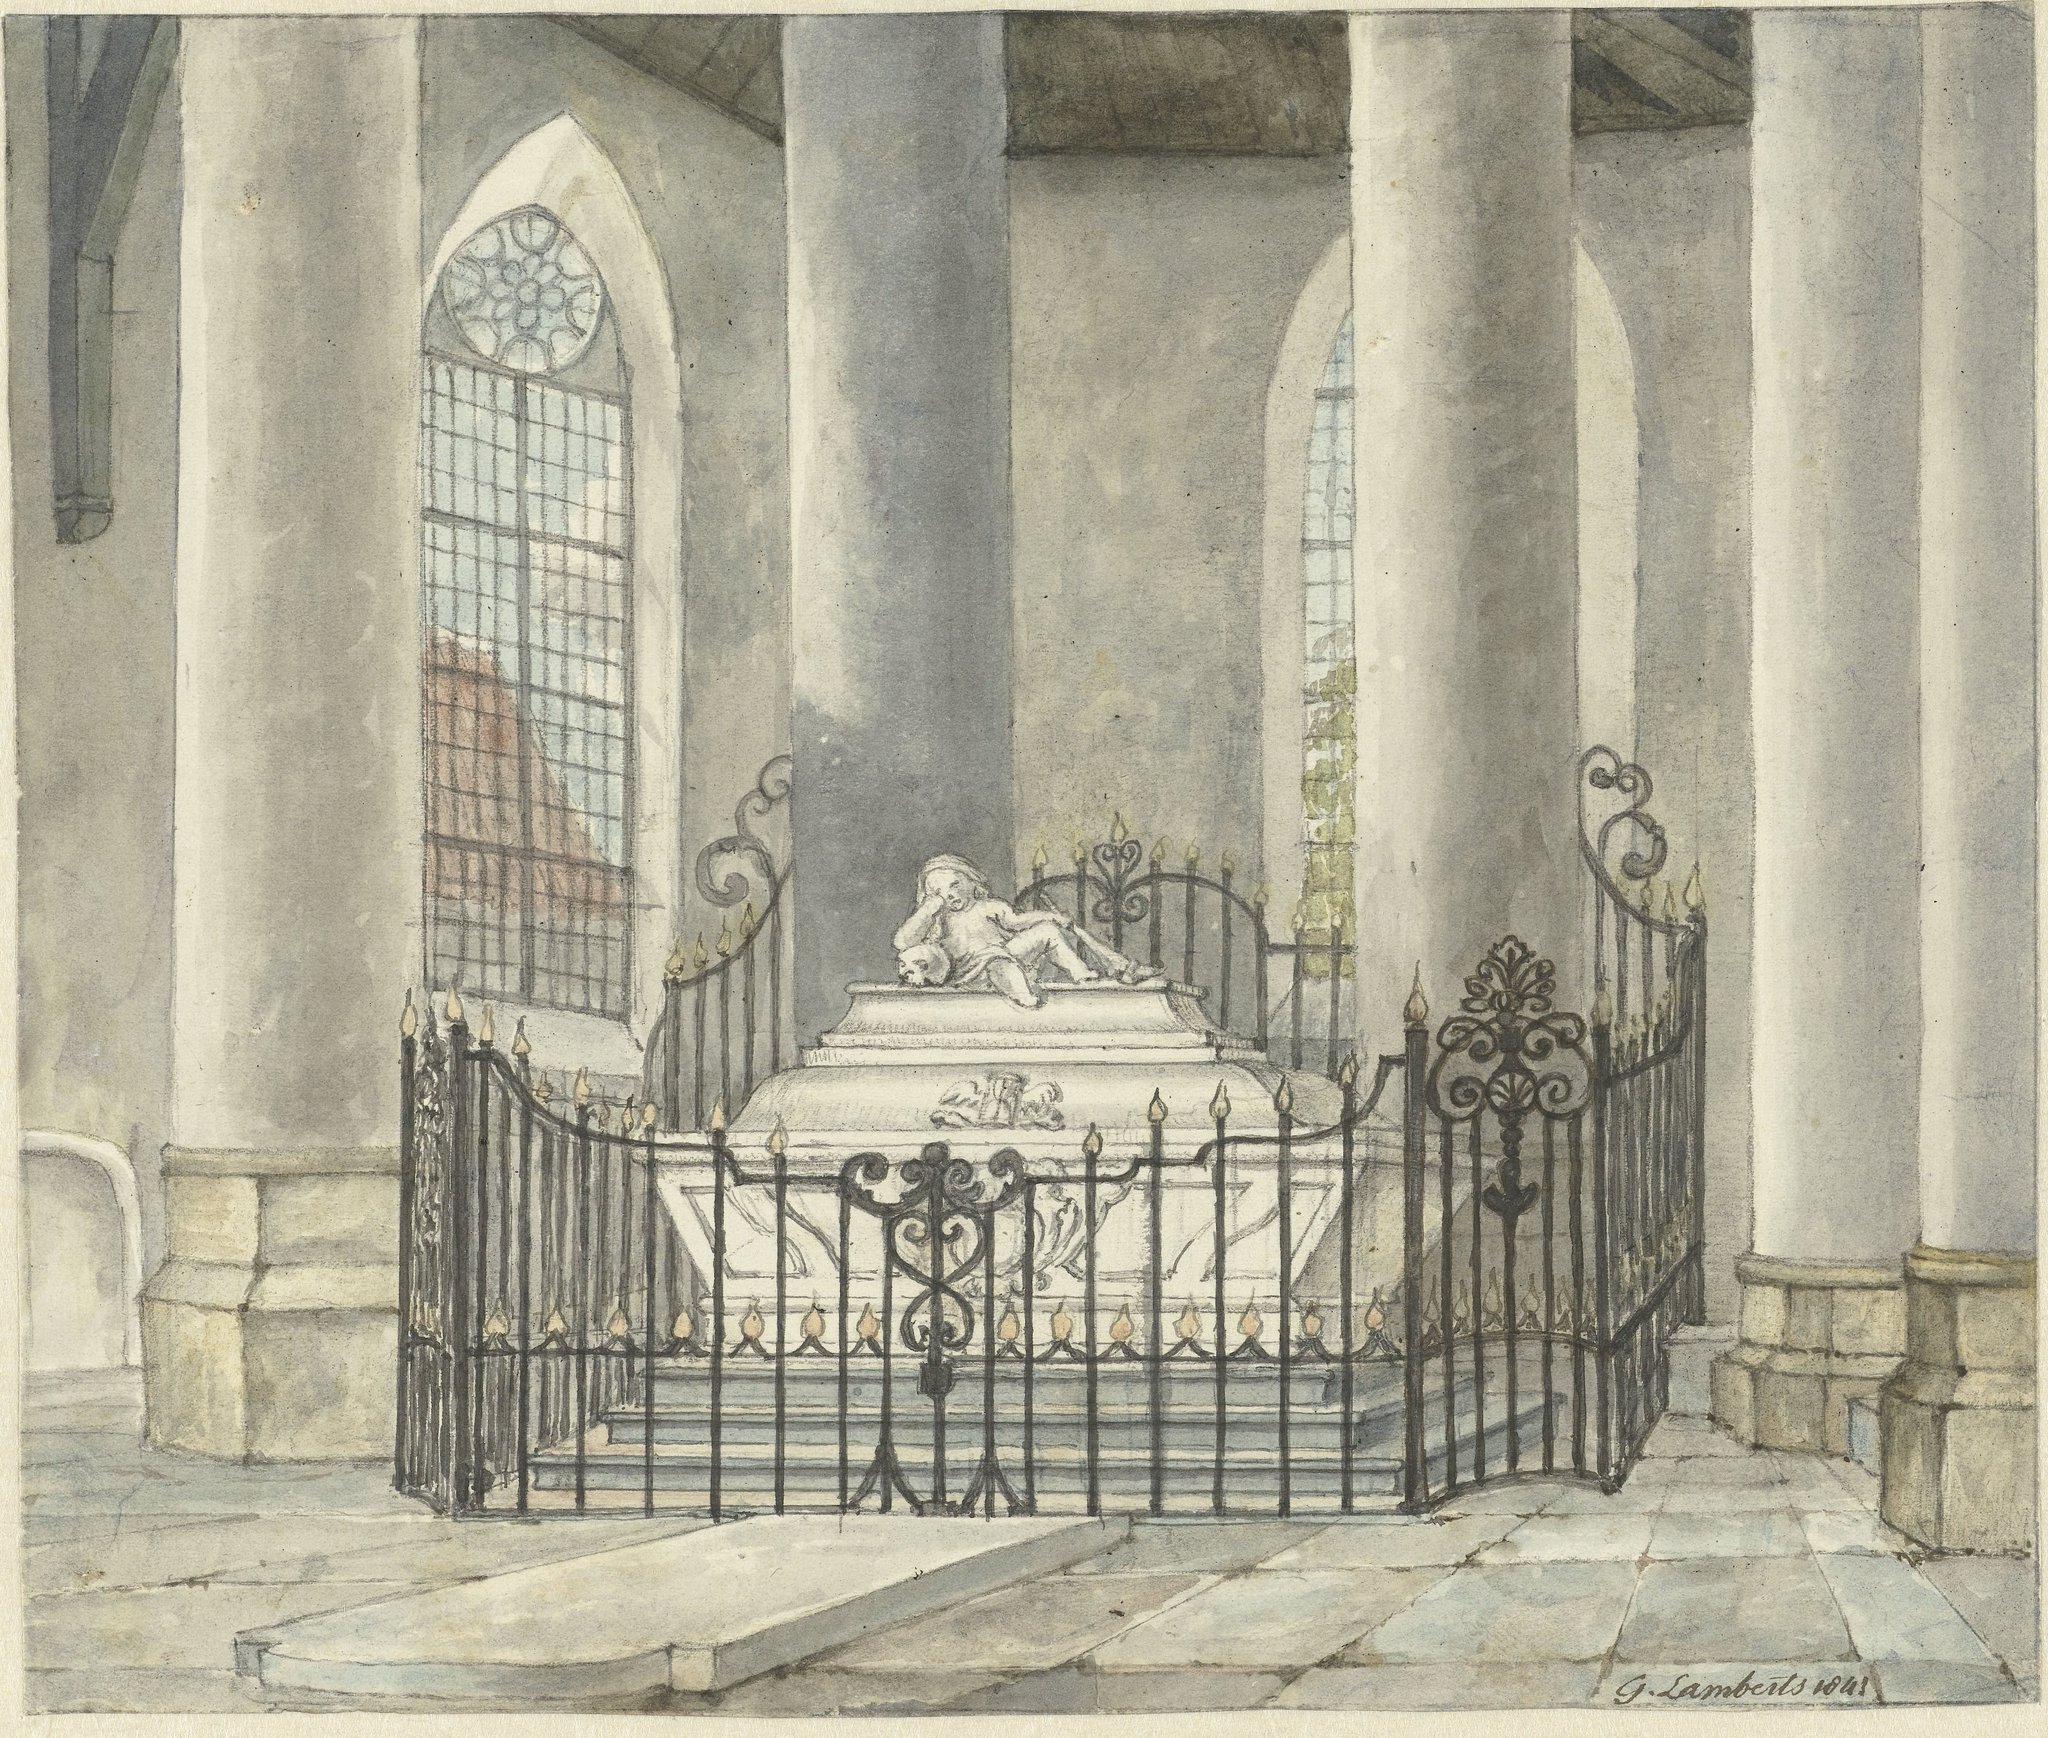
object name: drawing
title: Grafmonument van Catharina Alida van der Dussen, in een kerk te Culemborg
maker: gerrit lamberts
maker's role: bookseller, draughtsman, print maker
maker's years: 1776-1850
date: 1843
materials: chalk, ink, paper, watercolor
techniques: brush, pen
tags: historical persons, interior of church, grave-building, monumental tomb